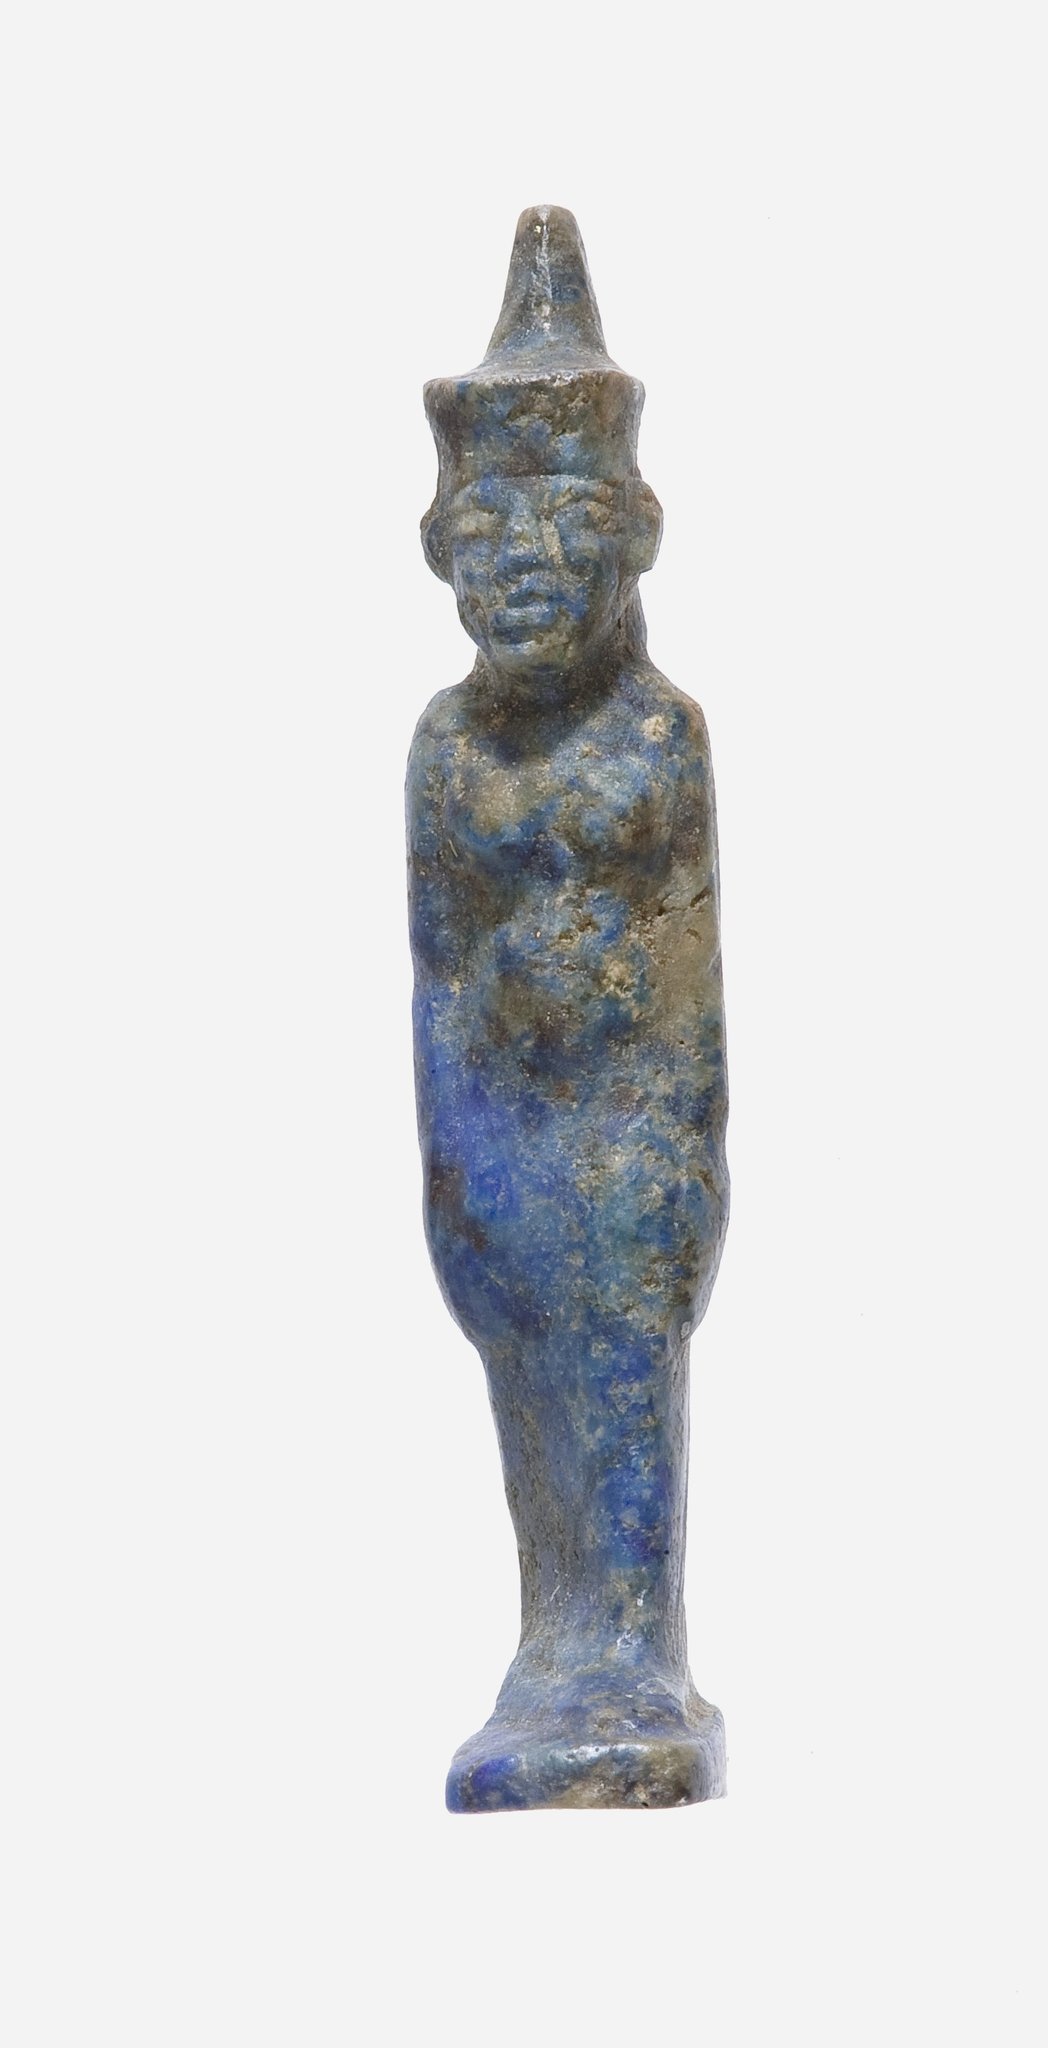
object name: amulet, queen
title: Neit Amulet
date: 664-332 BCE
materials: lapis lazuli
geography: egypt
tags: goddess